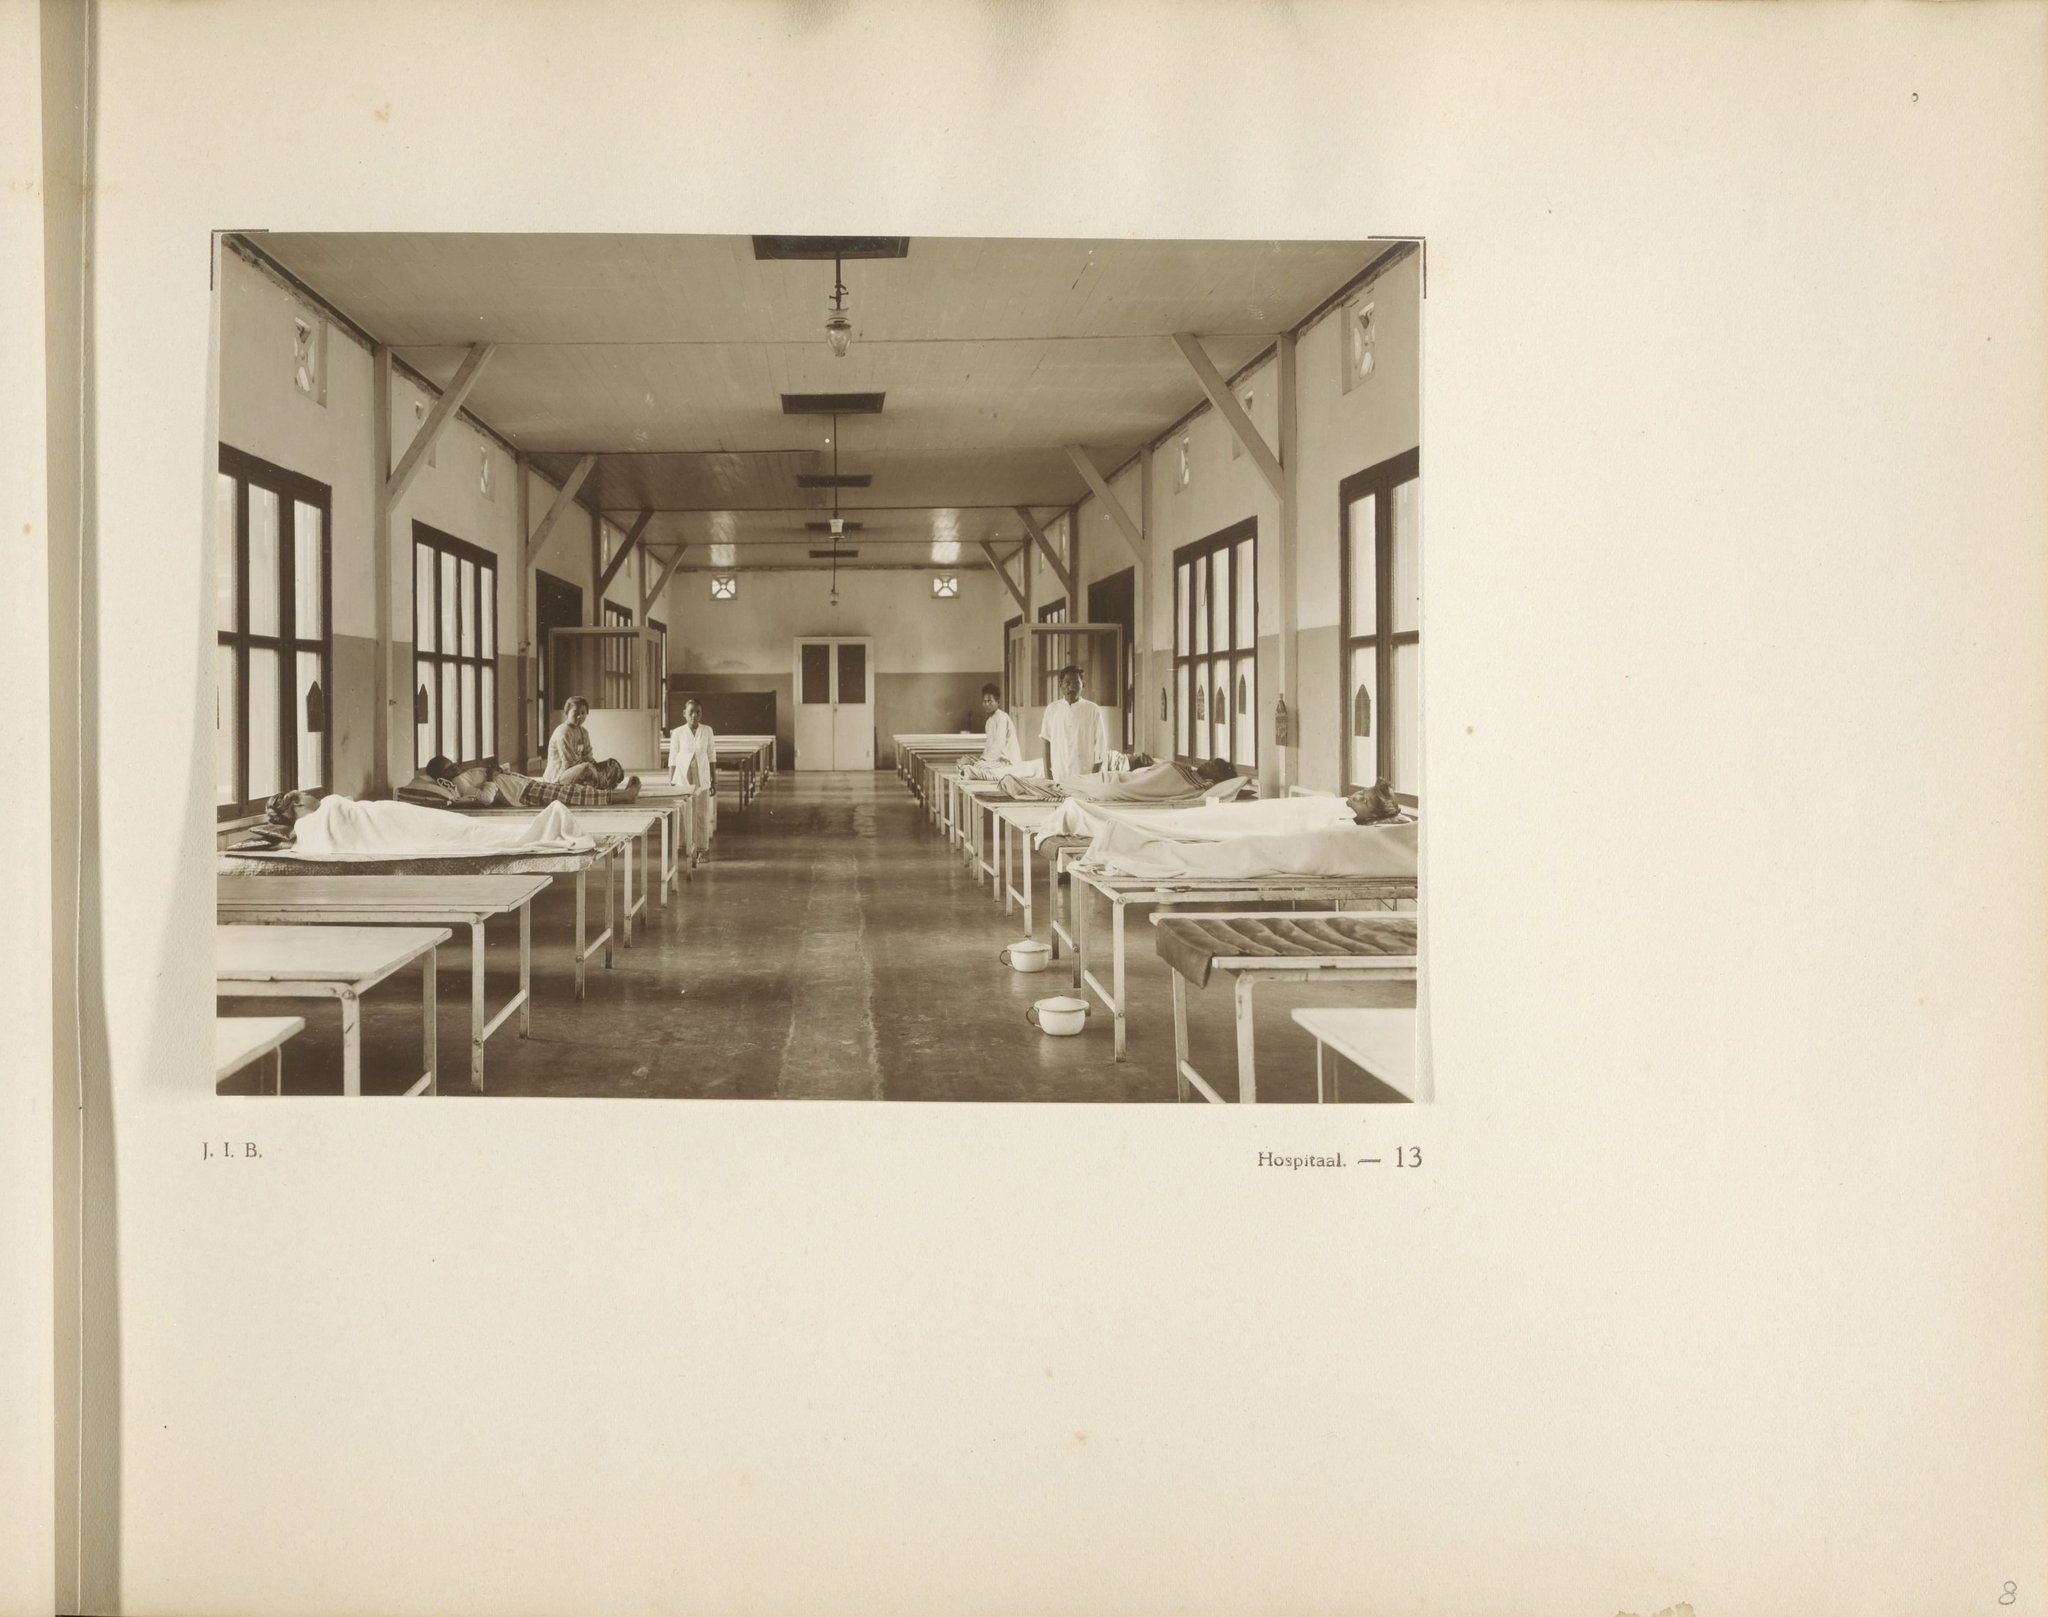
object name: photograph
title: Pagina 13 van fotoboek van de Algemeene Vereeniging van Rubberplanters ter Oostkust van Sumatra (A.V.R.O.S.)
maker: j.w. meyster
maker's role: fotograaf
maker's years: 1887-1945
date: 1924-1925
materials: paper, photographic support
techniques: printing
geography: sumatra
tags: (non-fruit) products of plants or trees: rubber, hospital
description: Boekpagina met een foto van een ziekenzaal van het Java Immigranten Bureau (J.I.B.). Onderdeel van een fotoboek van de Algemeene Vereeniging van Rubberplanters ter Oostkust van Sumatra (A.V.R.O.S.).